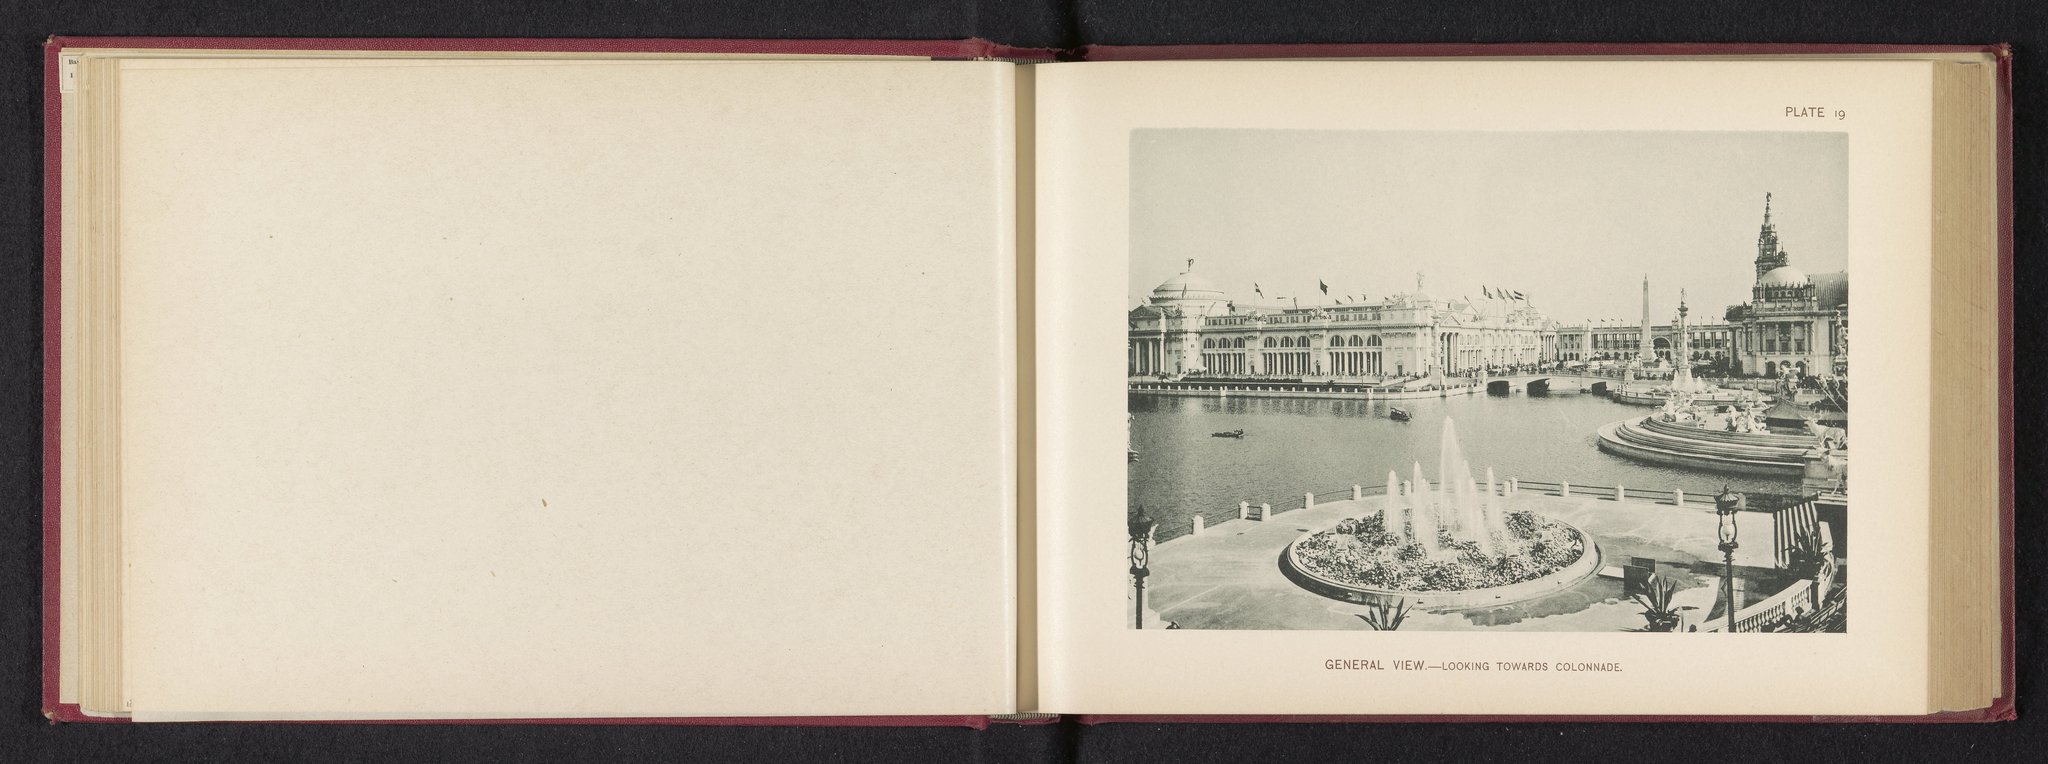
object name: photomechanical print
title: Gezicht op het centrale plein van de World's Columbian Exposition in Chicago in 1893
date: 1893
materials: paper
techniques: photograph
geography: chicago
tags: world fair, world exhibition, pond, pool, ornamental fountain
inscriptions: number: ‘Plate 19’